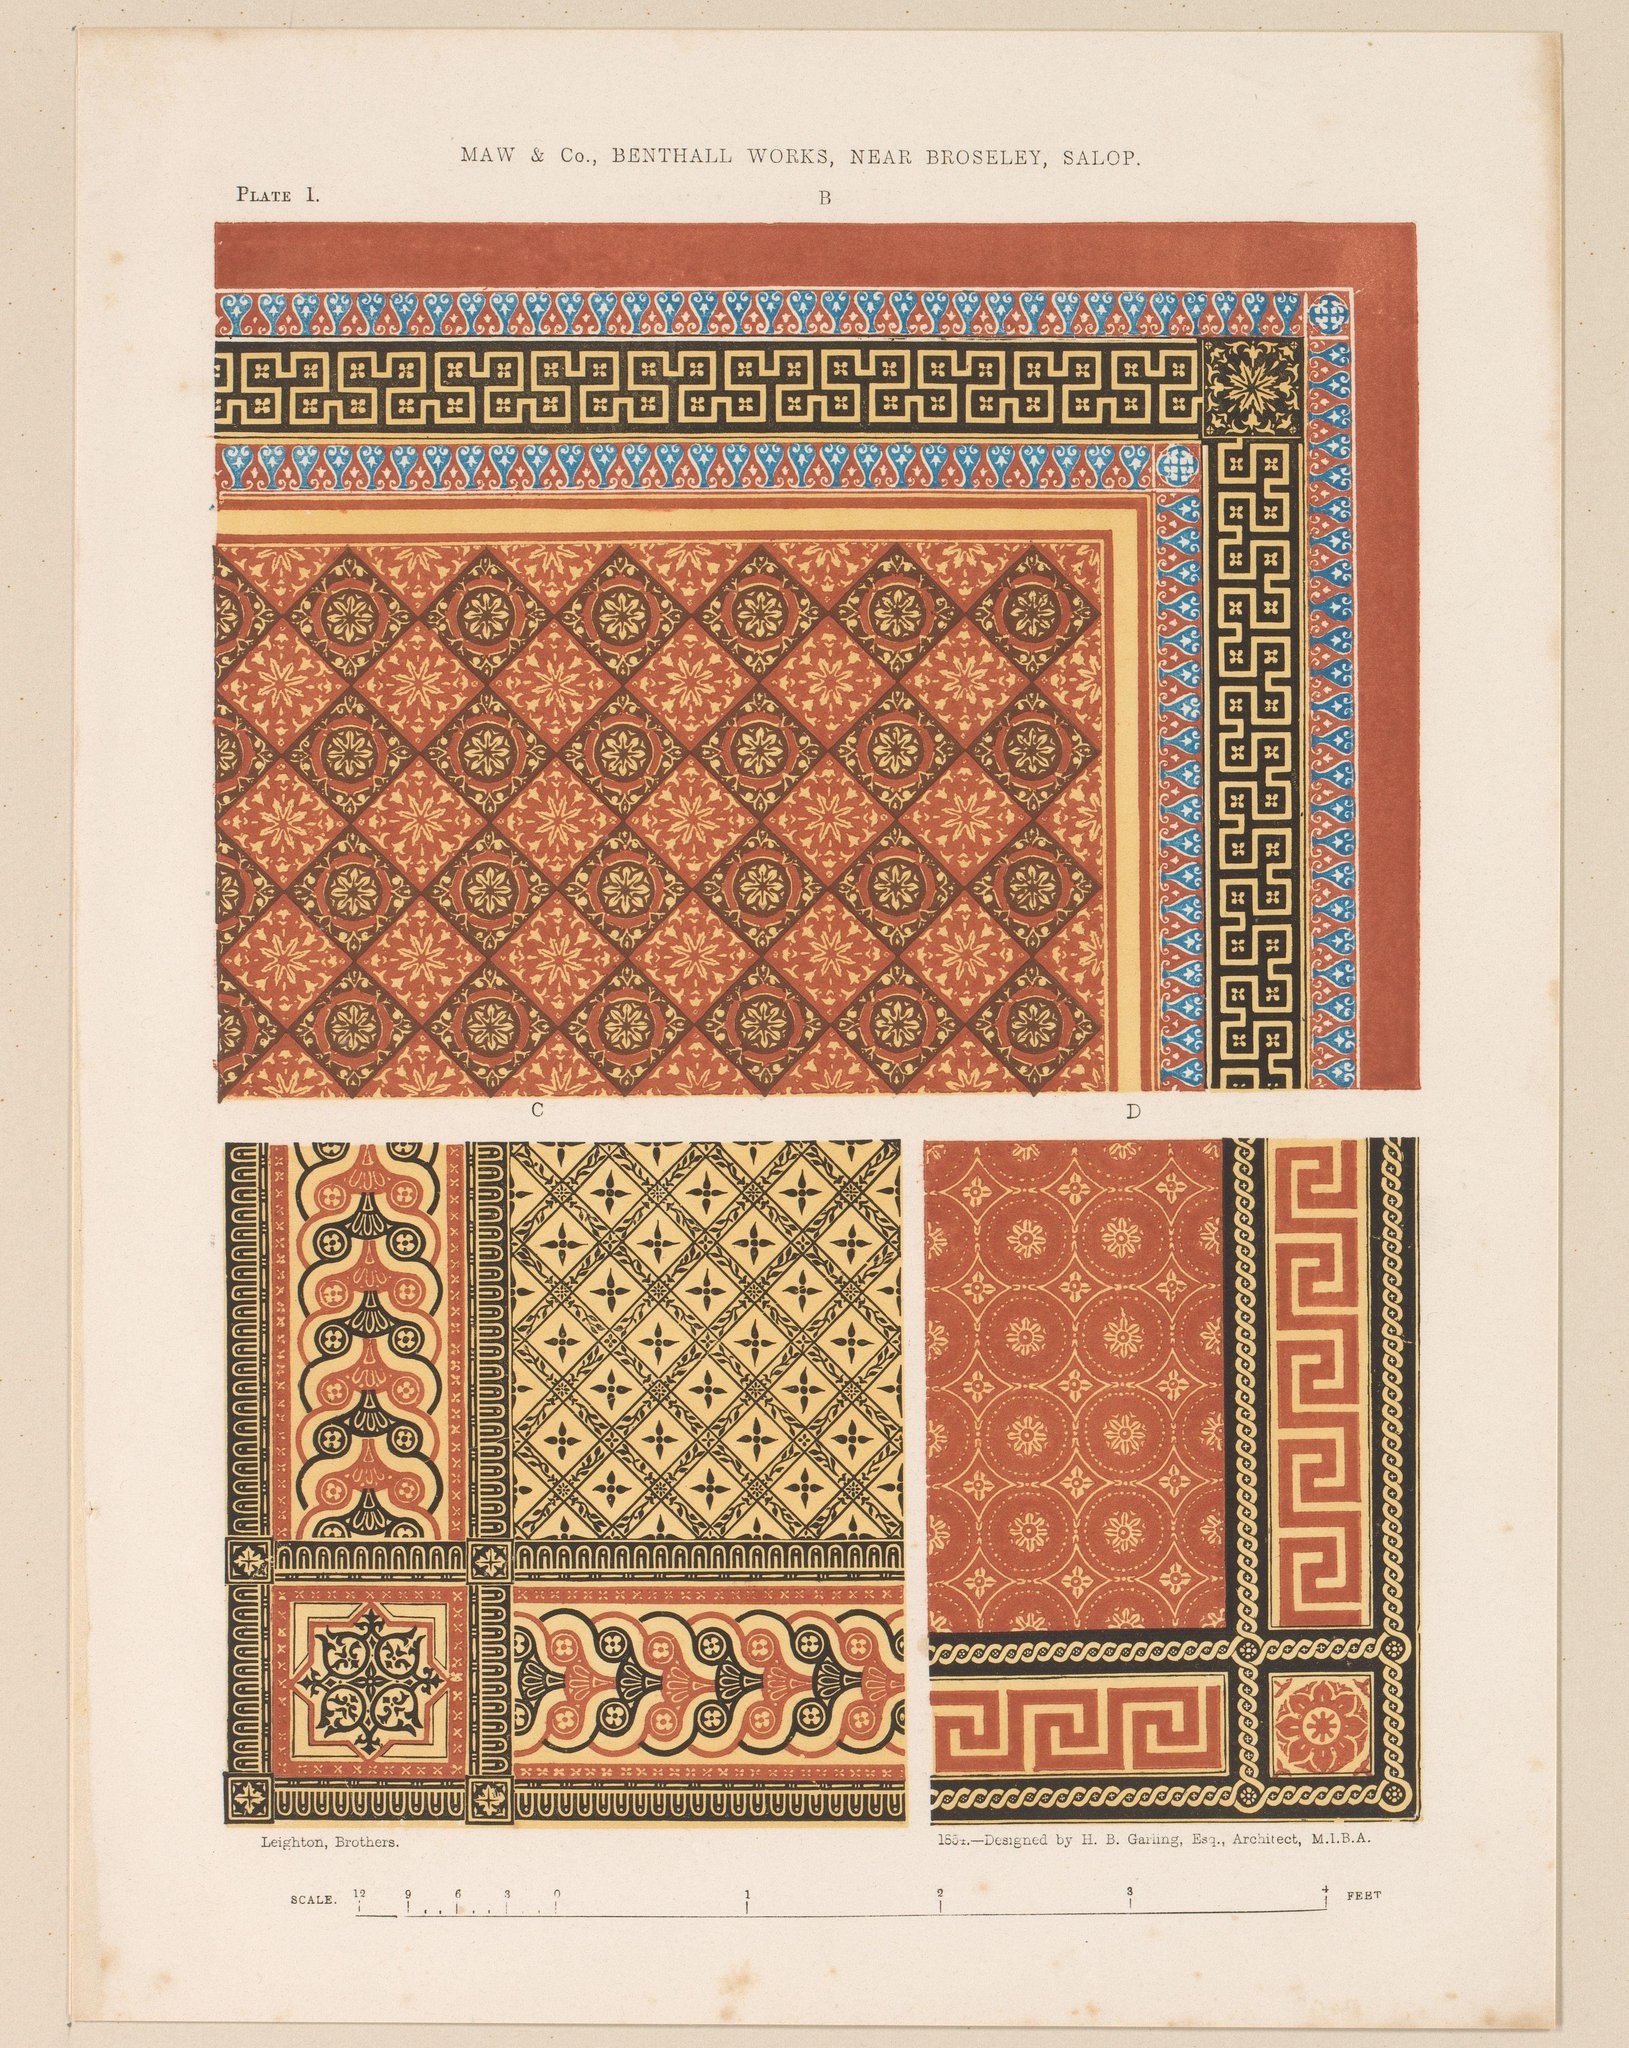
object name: print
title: Decoratiepatronen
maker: henry bayly garling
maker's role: designer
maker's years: 1822-1909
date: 1854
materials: paper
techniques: chromolithography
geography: england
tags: ornament ~ geometric motifs, tiles, bricks ~ building material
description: Patronen voor tegels. Plate I. Geproduceerd door 'Maw & Co, Benthall Works, near Broseley, Salop'.